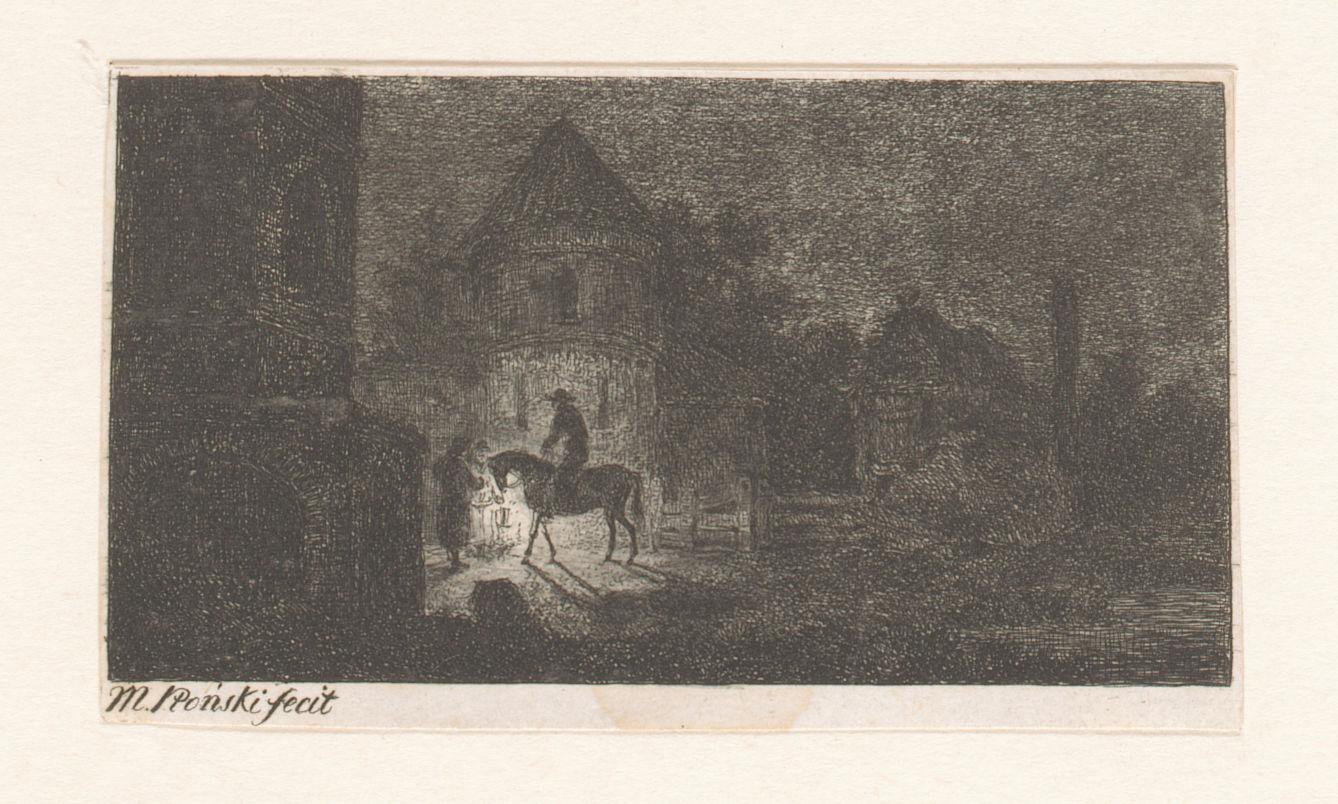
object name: print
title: Man en ruiter in nachtelijk stadsgezicht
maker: michał płoński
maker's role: print maker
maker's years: 1778-1812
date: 1788-1812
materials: paper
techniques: etching, intaglio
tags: night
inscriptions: collector's mark: Lugt 2227, collector's mark: Lugt 2228